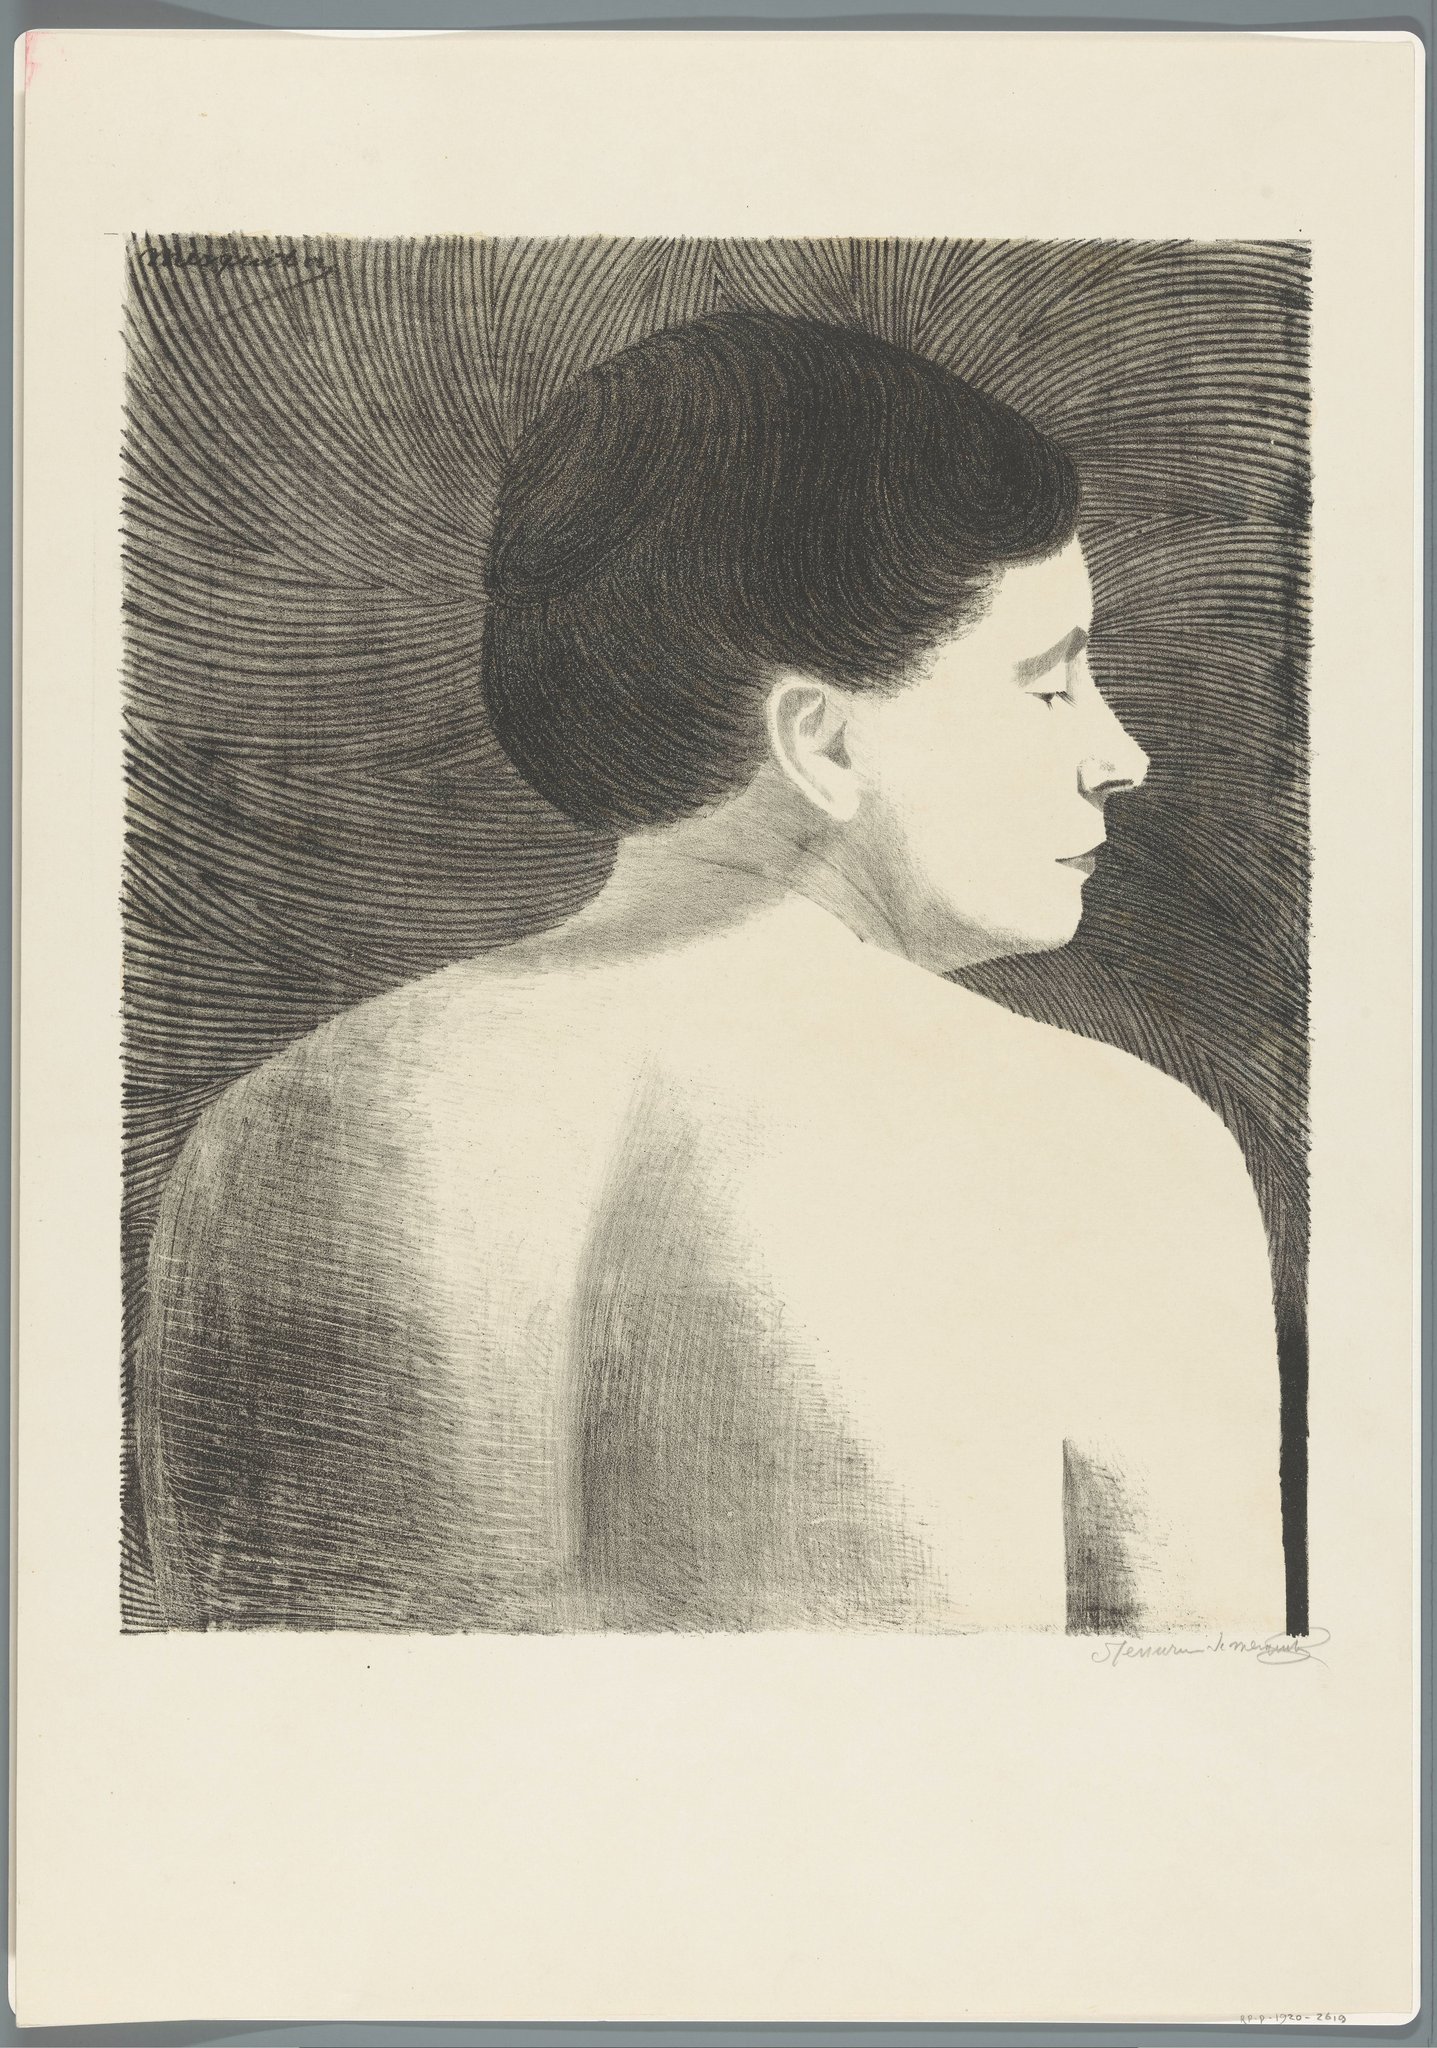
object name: print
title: Portrait of Betsie Jessurun de Mesquita-Pinédo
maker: samuel jessurun de mesquita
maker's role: draughtsman, print maker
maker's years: 1868-1944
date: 1920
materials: paper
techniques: tone lithography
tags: woman (showing herself) undressed, quasi-nude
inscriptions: collector's mark: Lugt 2228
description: De Mesquita’s wife Betsie was a beloved subject and therefore appears frequently in his work. She was born Elisabeth Pinedo. Because of their Sephardic, almost noble, background, Samuel and Betsie believed they were in less danger and did not go into hiding. After being arrested, they were deported to Auschwitz and murdered on the same day shortly upon arriving there.